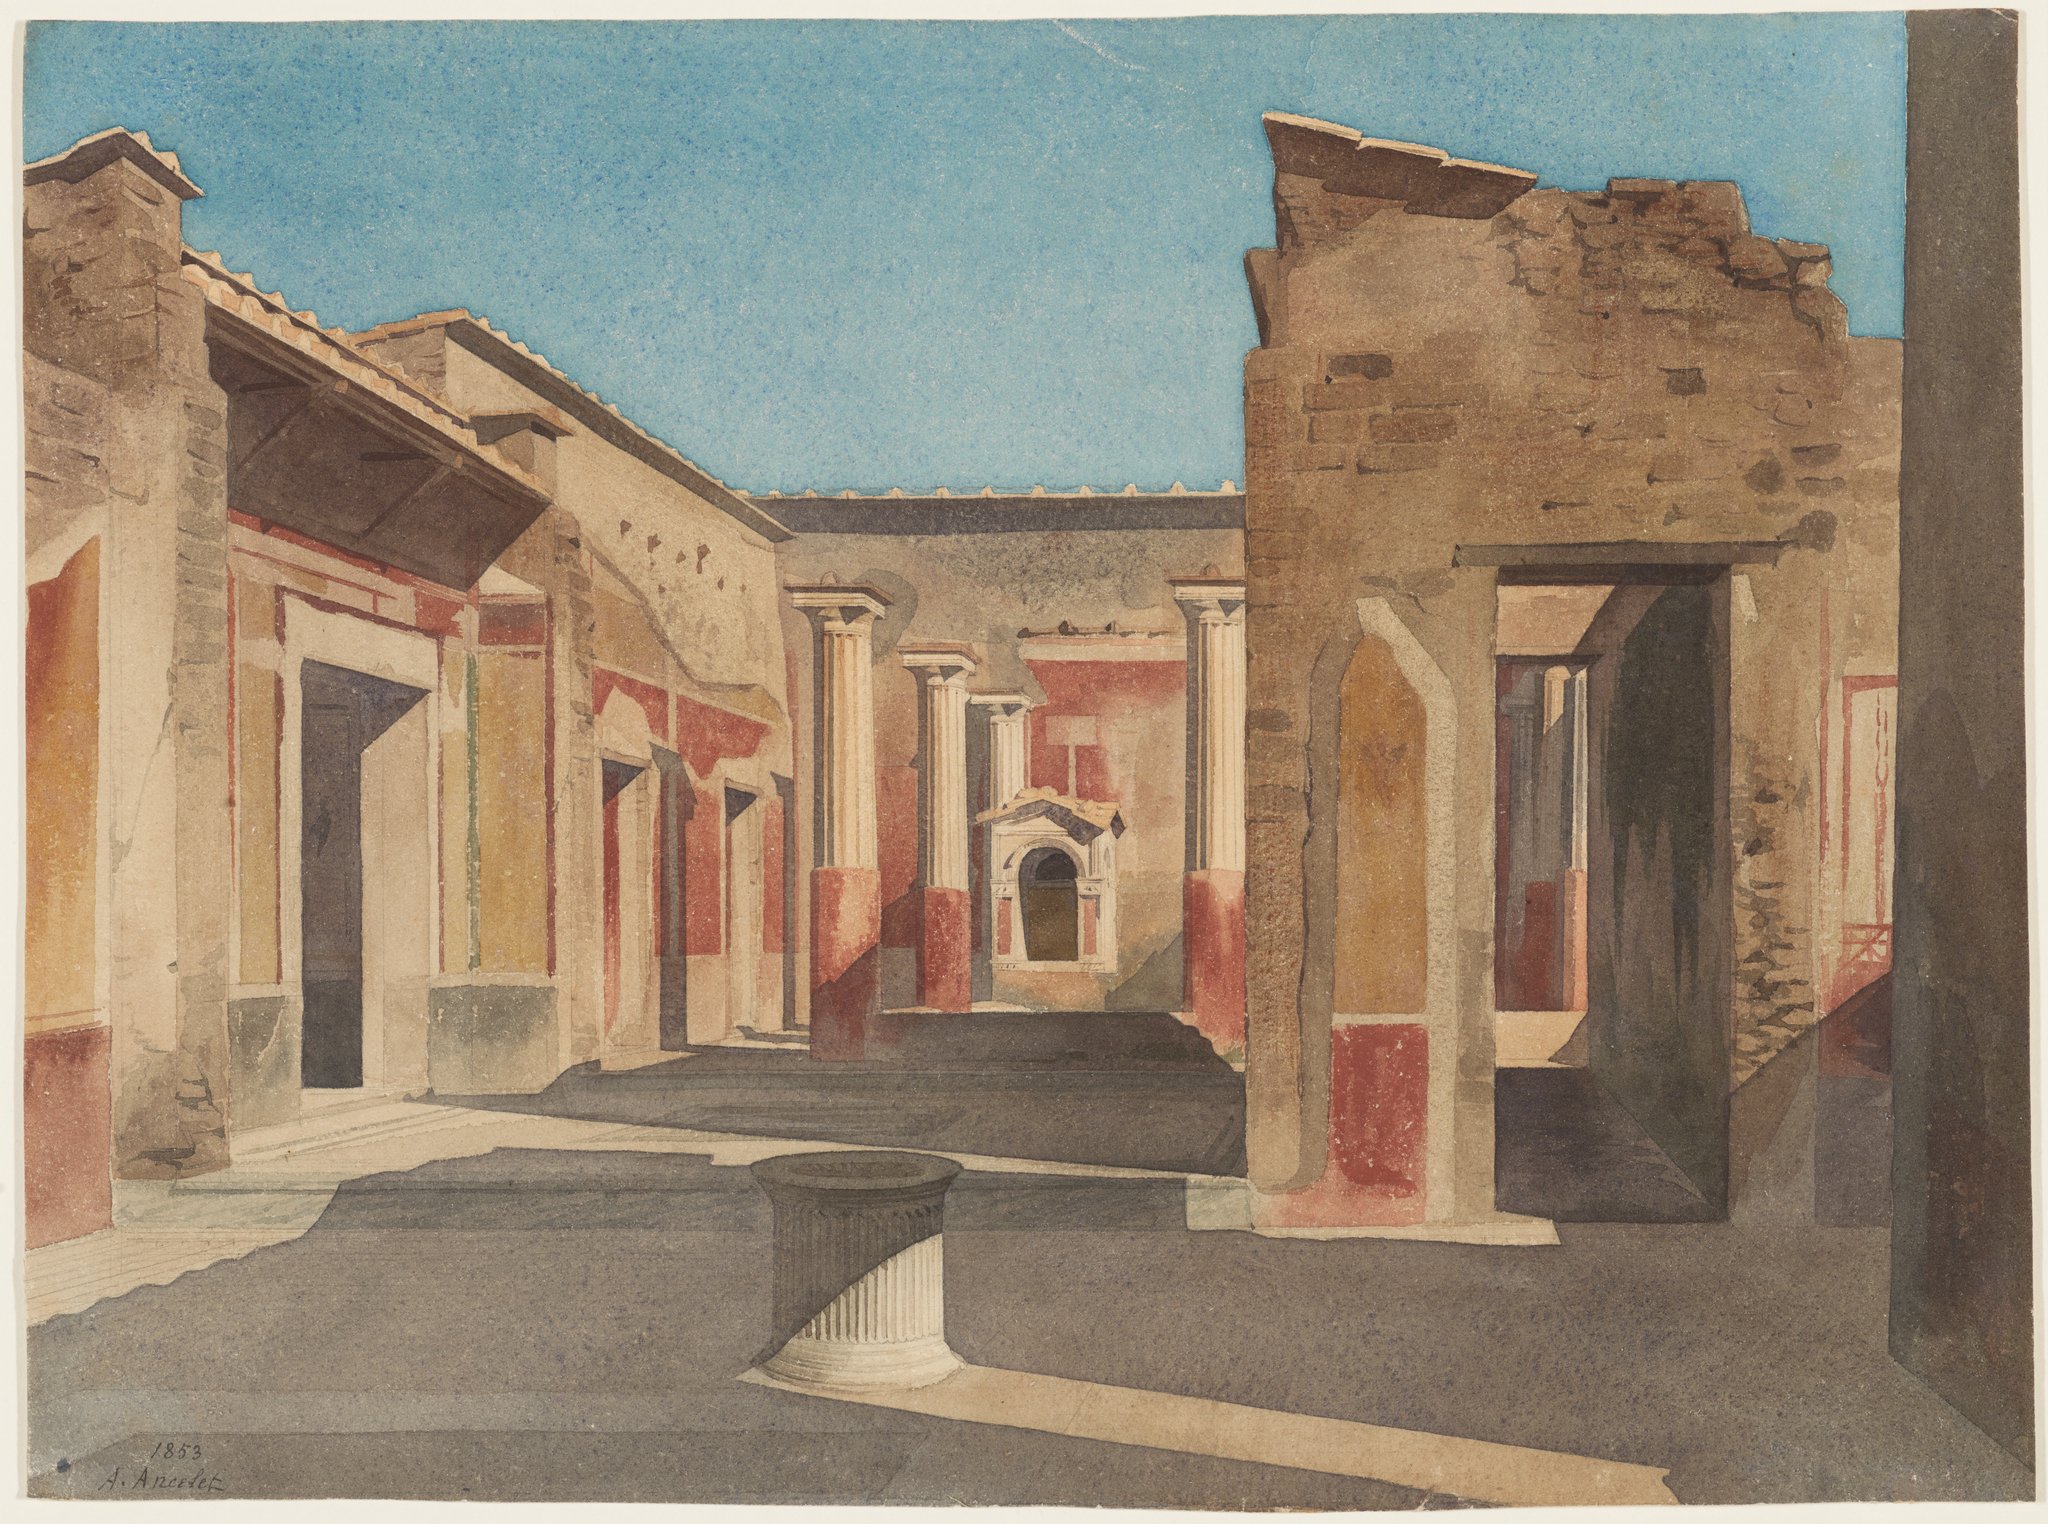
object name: drawing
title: Ruins at Pompeii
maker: gabriel-auguste ancelet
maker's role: artist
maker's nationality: french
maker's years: 1829-1895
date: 1853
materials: graphite, watercolor